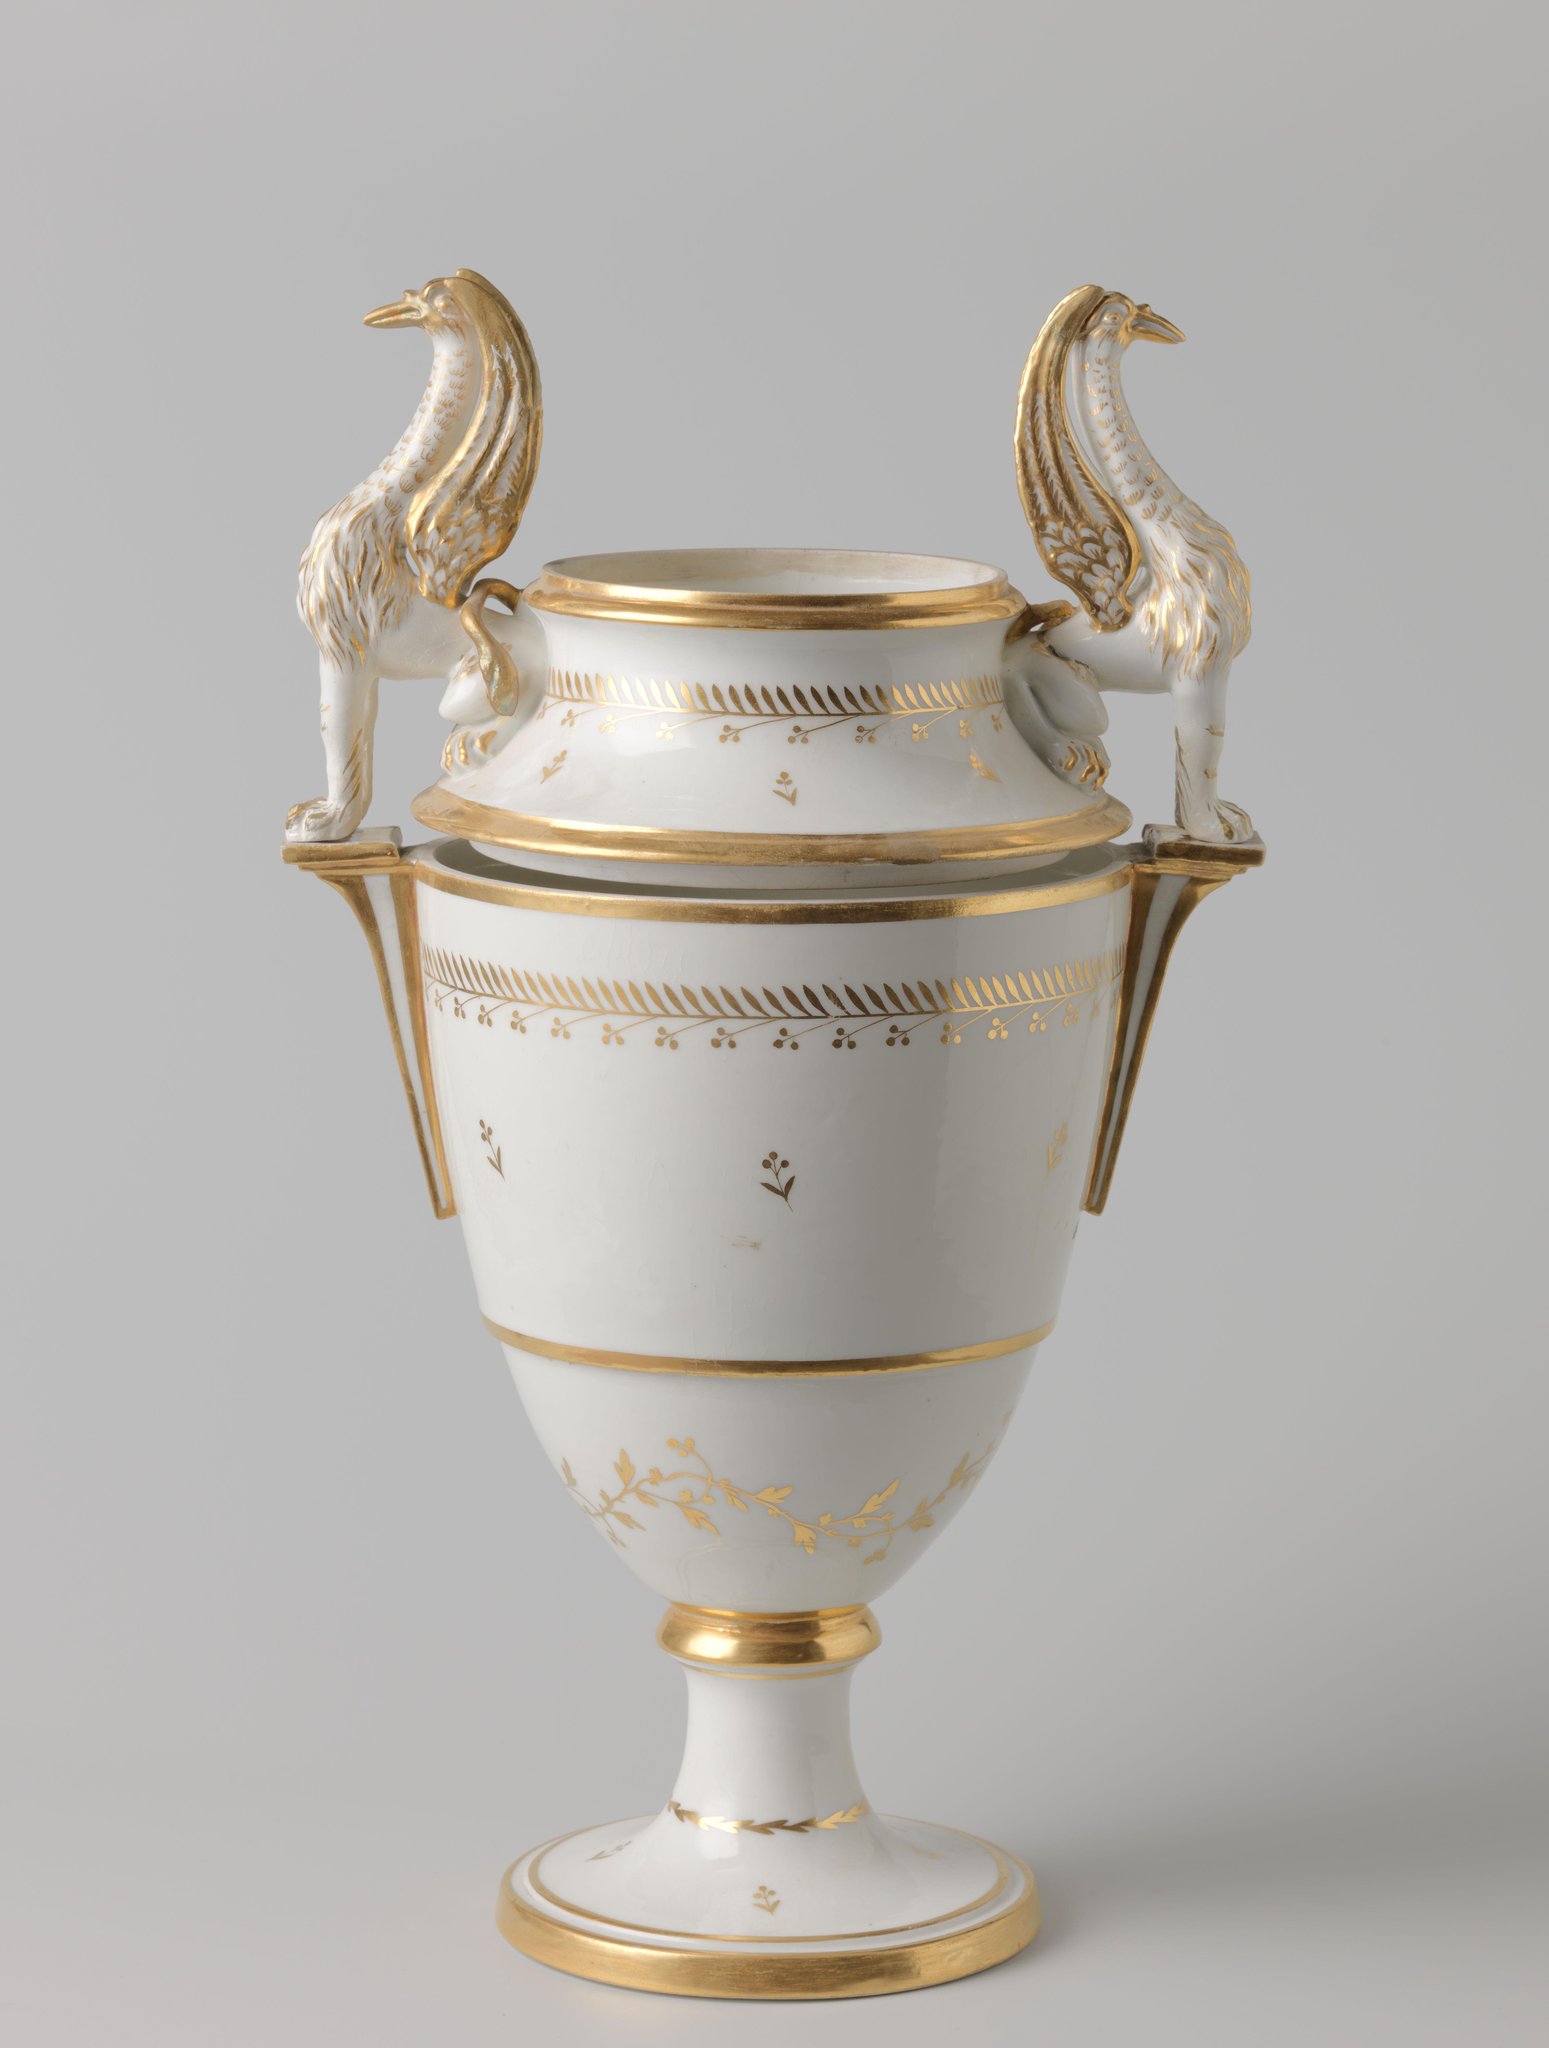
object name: lid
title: Punt van deksel van kastanjevaas versierd met griffioenen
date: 1810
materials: porcelain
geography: netherlands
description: Punt van deksel van kastanjevaas met oren in de vorm van griffioenen.